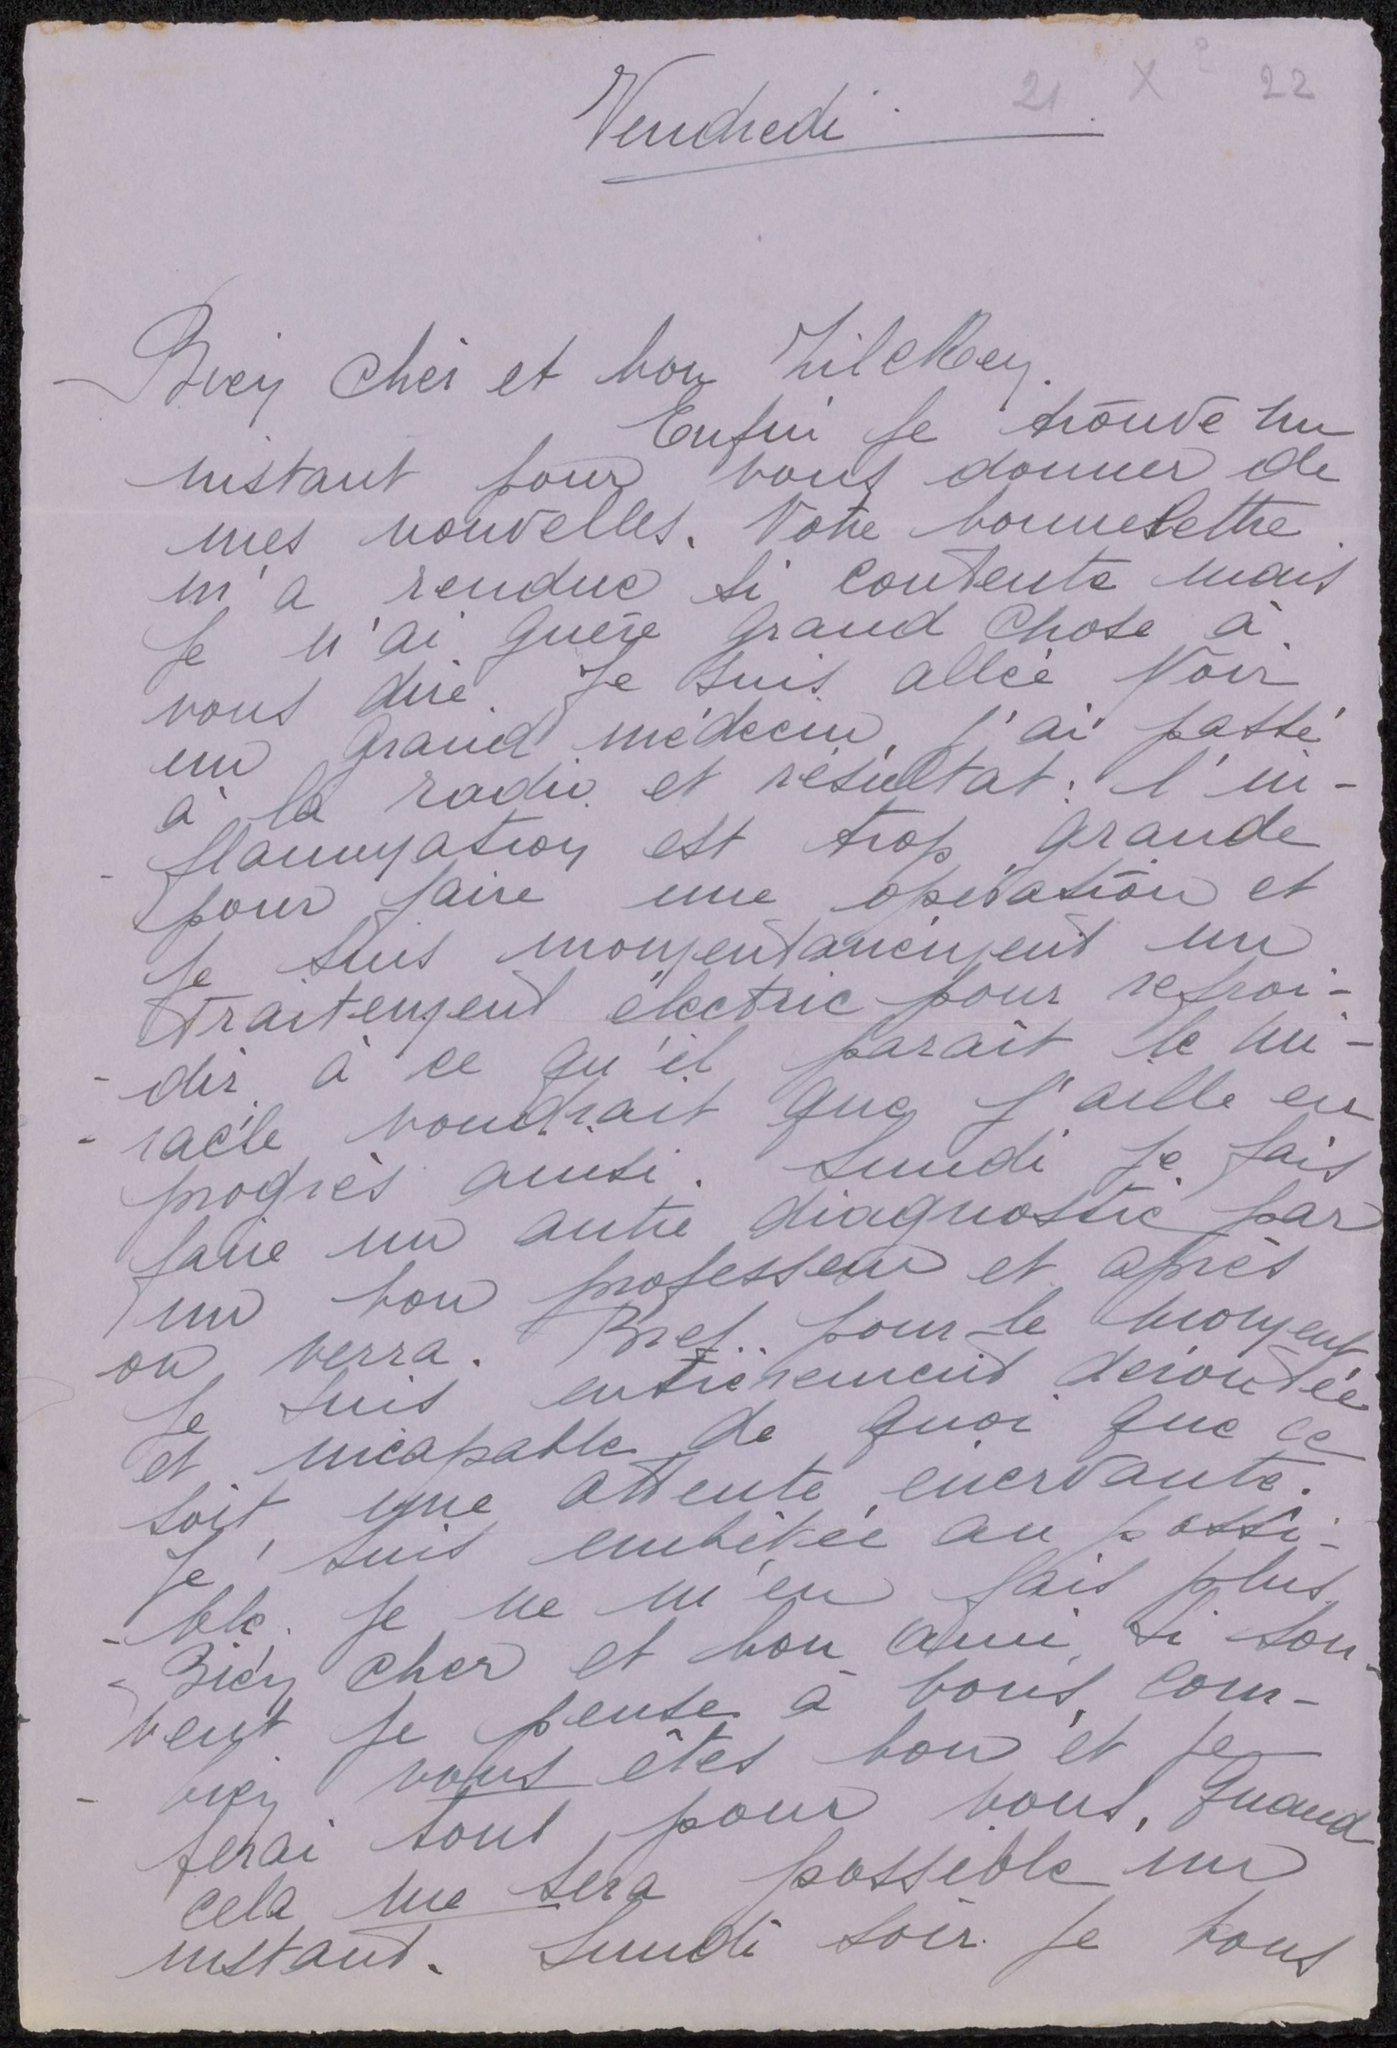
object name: letter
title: Brief aan Philip Zilcken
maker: rose imel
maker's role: draughtsman, painter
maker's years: 1901-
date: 1911-1930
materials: ink, paper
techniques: pen, writing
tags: paris, publisher, painter, draughtsman, philip zilcken, diseases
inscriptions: collector's mark: ‘RPK’